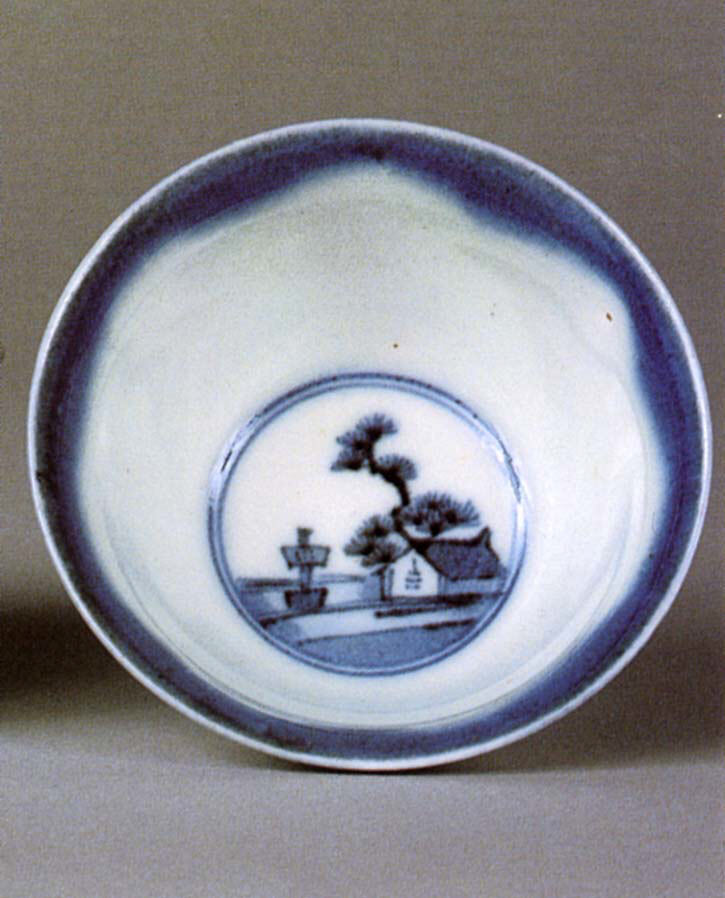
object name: one of a pair of cup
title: One of a Pair of Cups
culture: japanese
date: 1701-1733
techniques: underglaze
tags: houses,trees